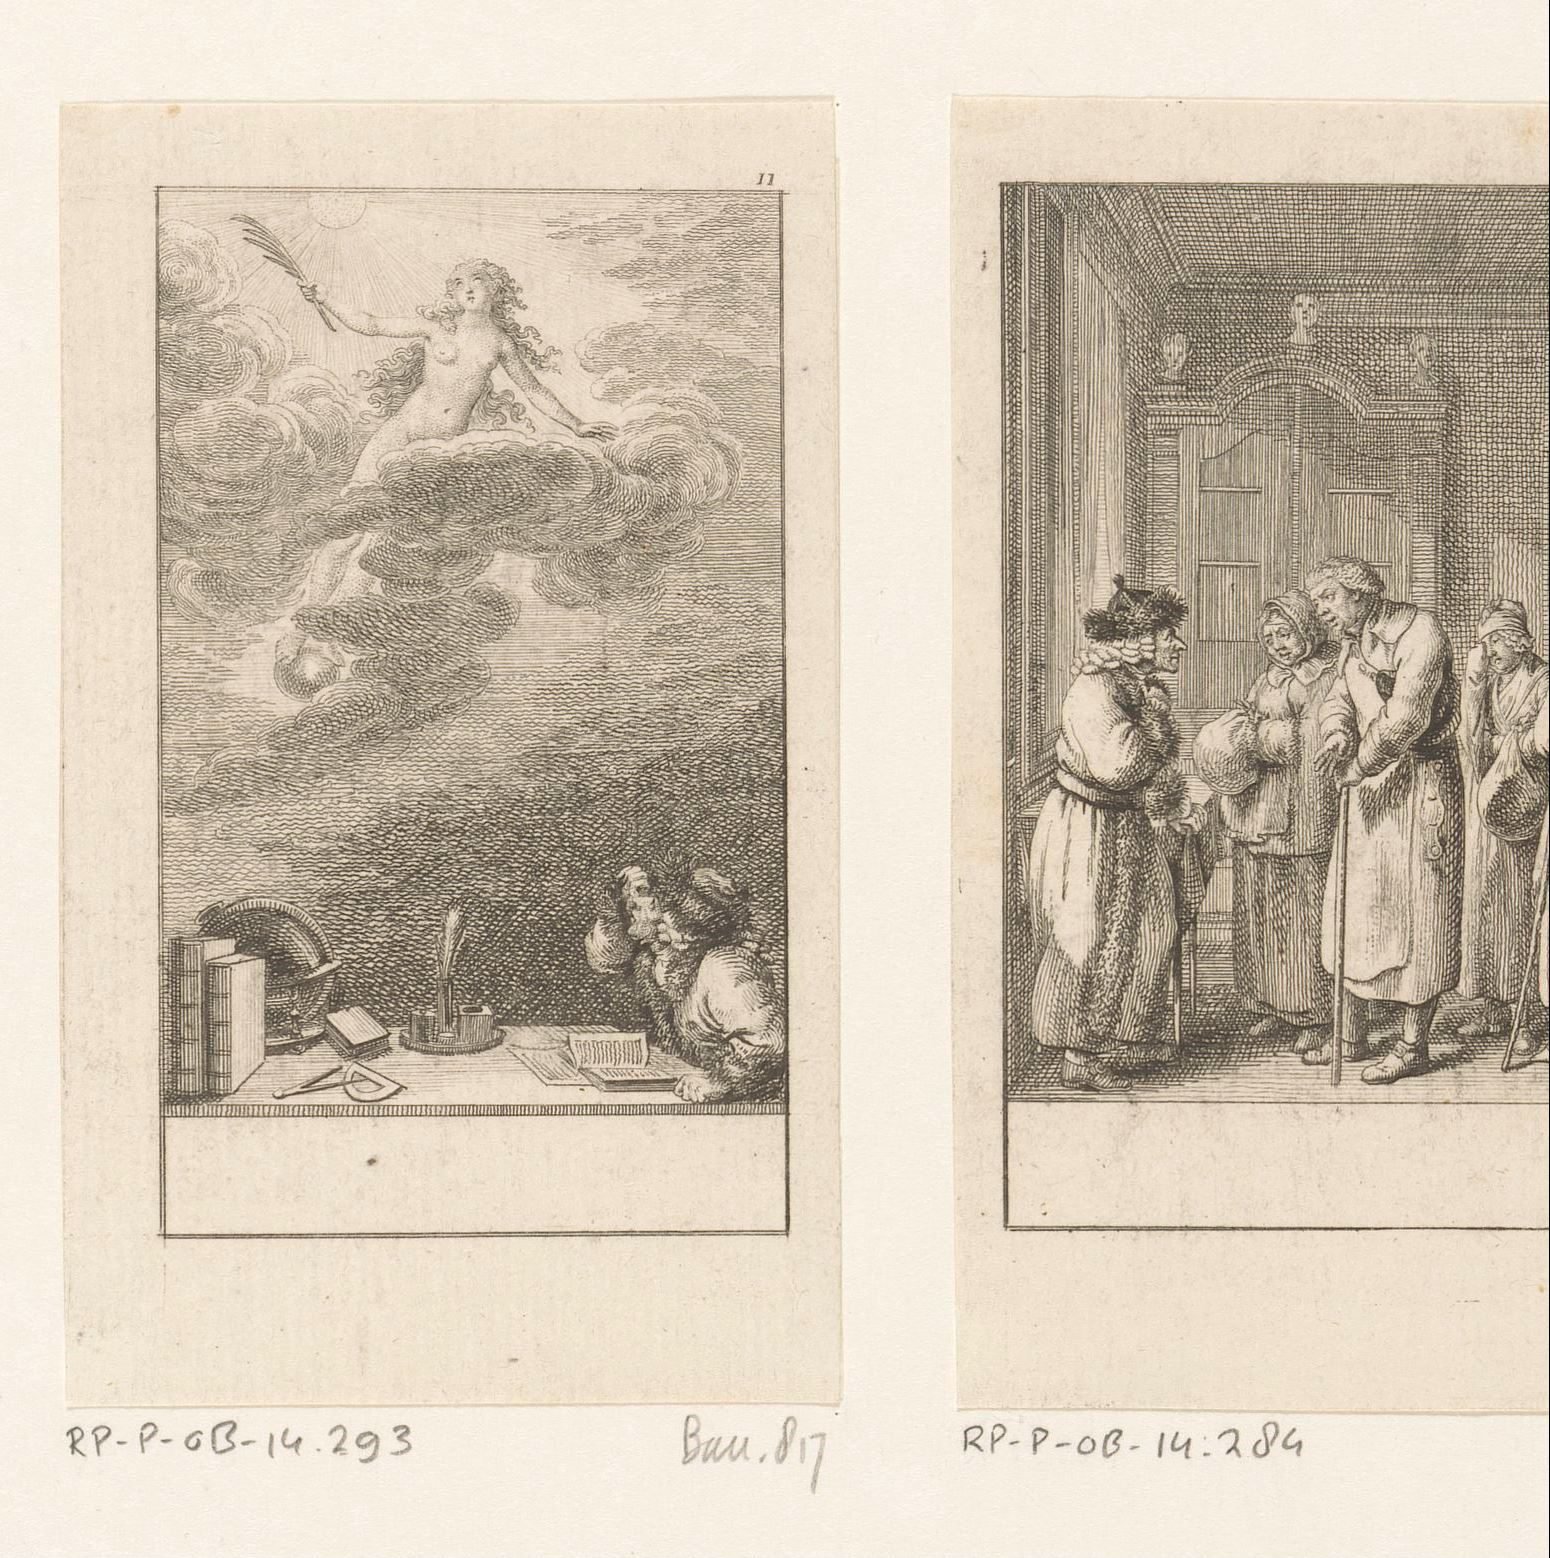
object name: print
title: Voltaire en zijn muze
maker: daniel nikolaus chodowiecki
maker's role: draughtsman, print maker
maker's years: 1726-1801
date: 1781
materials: paper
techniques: etching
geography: berlin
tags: paris, voltaire, writing-table, writing-desk, trees: palm-tree (+ branch, stick), sitting or standing on clouds, globe, single muses, male sex; man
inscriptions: collector's mark: Lugt 2228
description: Deze prent behoort tot een serie van twaalf prenten, vervaardigd voor de geschriften van Voltaire. Prent gebruikt voor: Almanac historique généalogique pour l'année 1782. A Berlin. Berlijn: L'Academie, 1781.